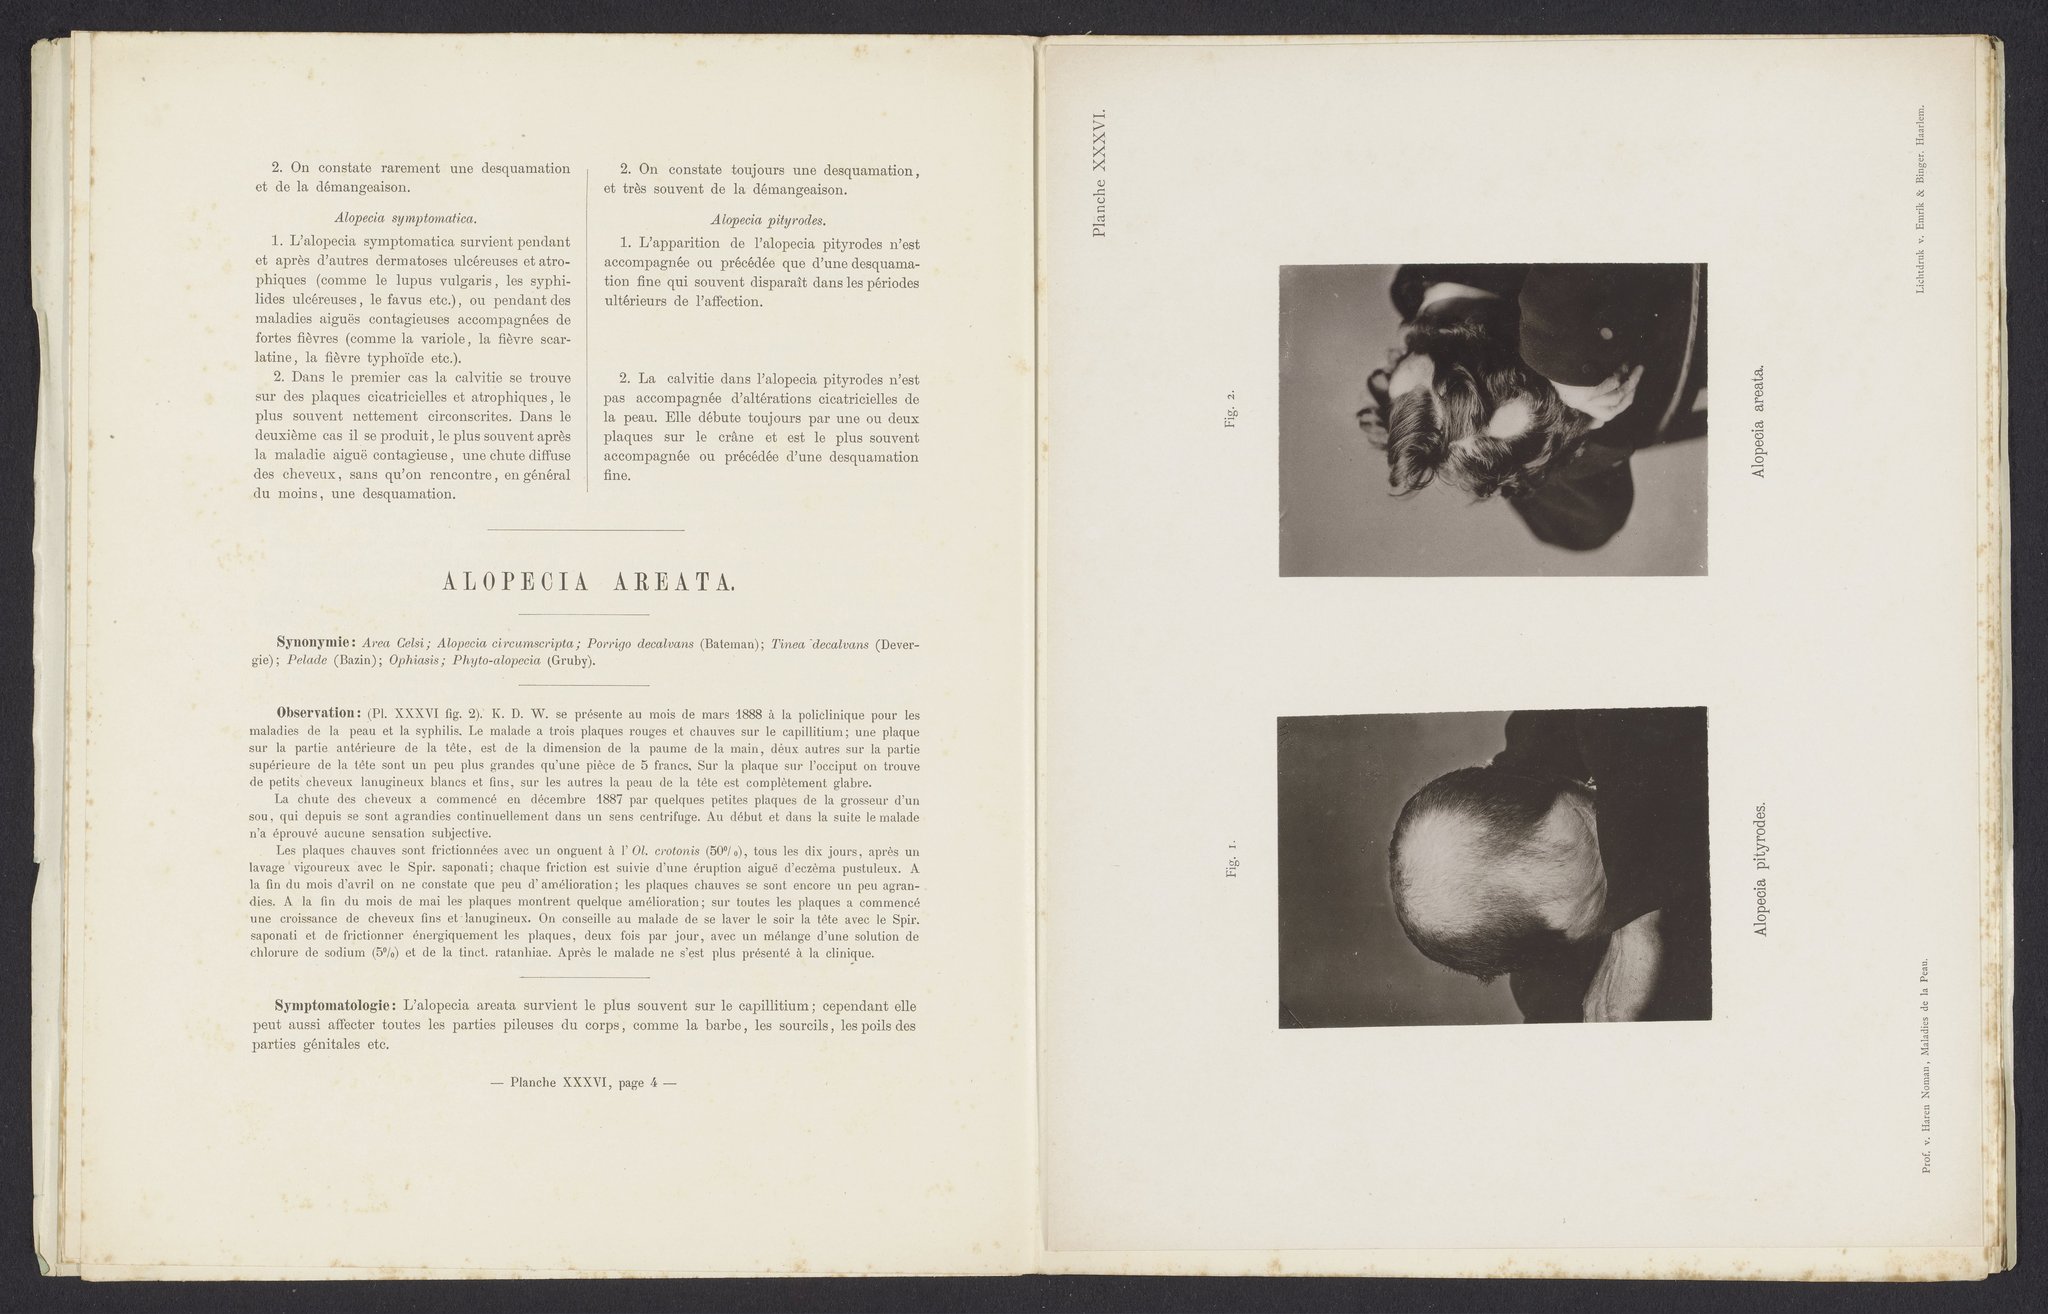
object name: page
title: Patiënten lijdend aan de huidziekte 'alopecia pityrodes' en 'alopecia areata'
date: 1883-1893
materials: paper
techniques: photograph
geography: haarlem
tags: head (human), skin and venereal diseases, hair, adult man, baldness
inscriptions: number: ‘Planche XXXVI. / Fig. 1. / Fig. 2.’